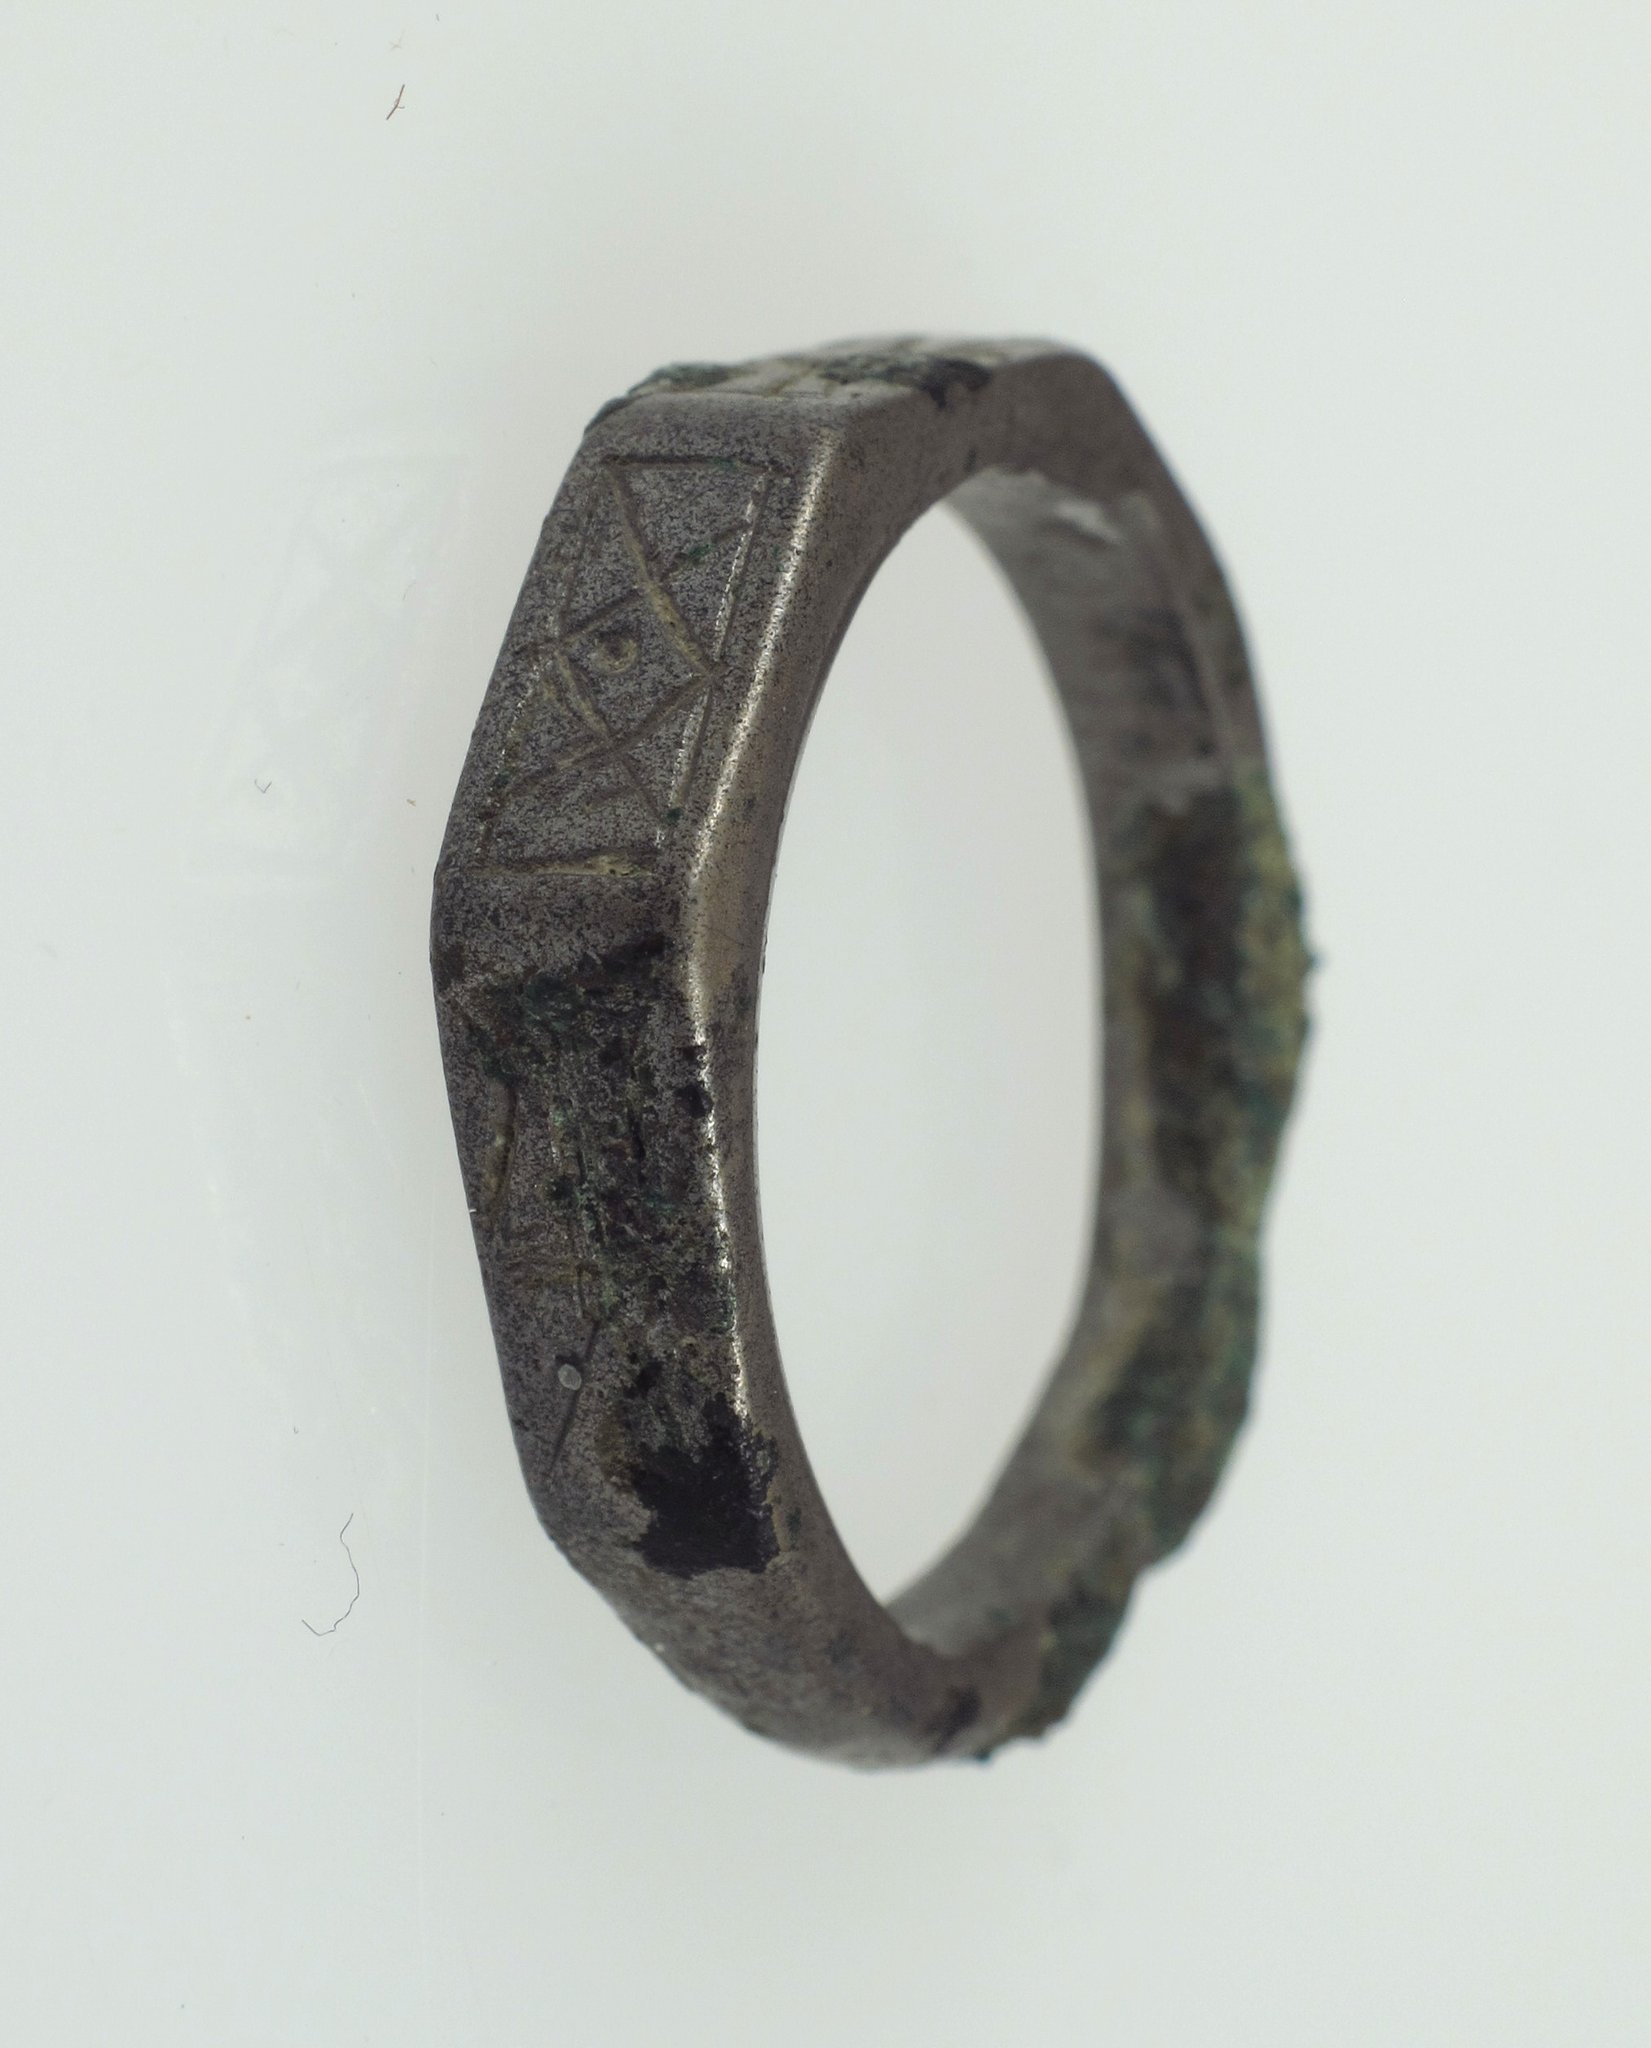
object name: ring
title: Finger Ring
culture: frankish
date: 601-700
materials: silver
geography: northern france